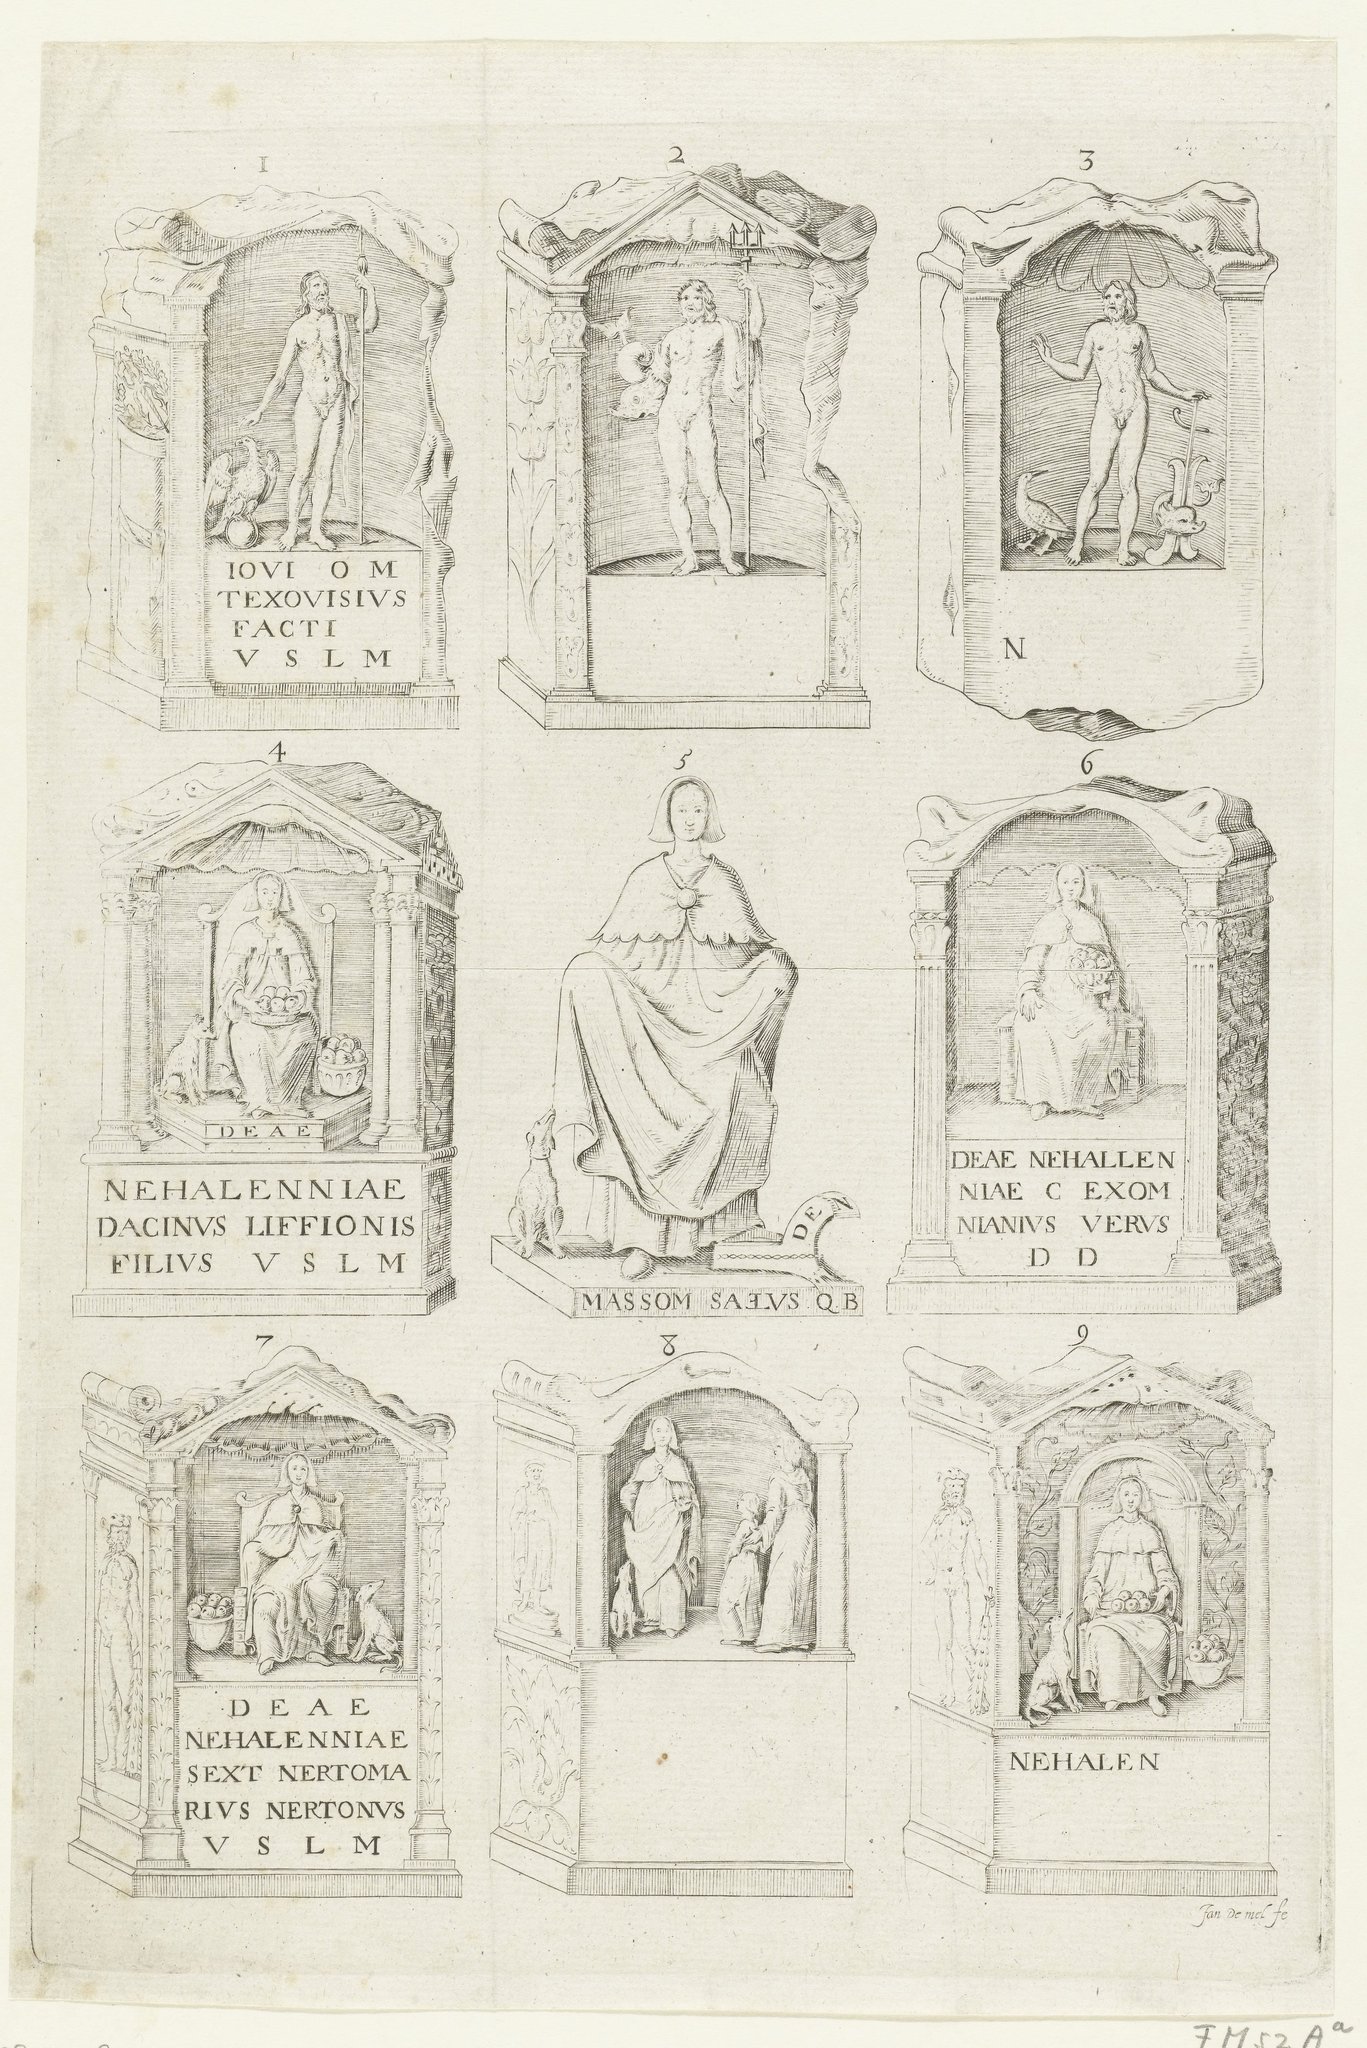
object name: historical object representation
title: Altaren met Nehalennia en andere goden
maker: jan de mel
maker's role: print maker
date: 1648-1650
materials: paper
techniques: engraving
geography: netherlands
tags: other foreign deities included in the classical pantheon (with name)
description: Blad met overzicht van altaren met Nehalennia en andere goden, genummerd 1-9. Afkomstig uit: Olivier de Wree, Historiae comitum Flandriae libri prodromiduo, Lucas van den Kerchove, Brugge 1650. Tweede staat waarin pagina en nummer rechtsboven zijn verwijderd.